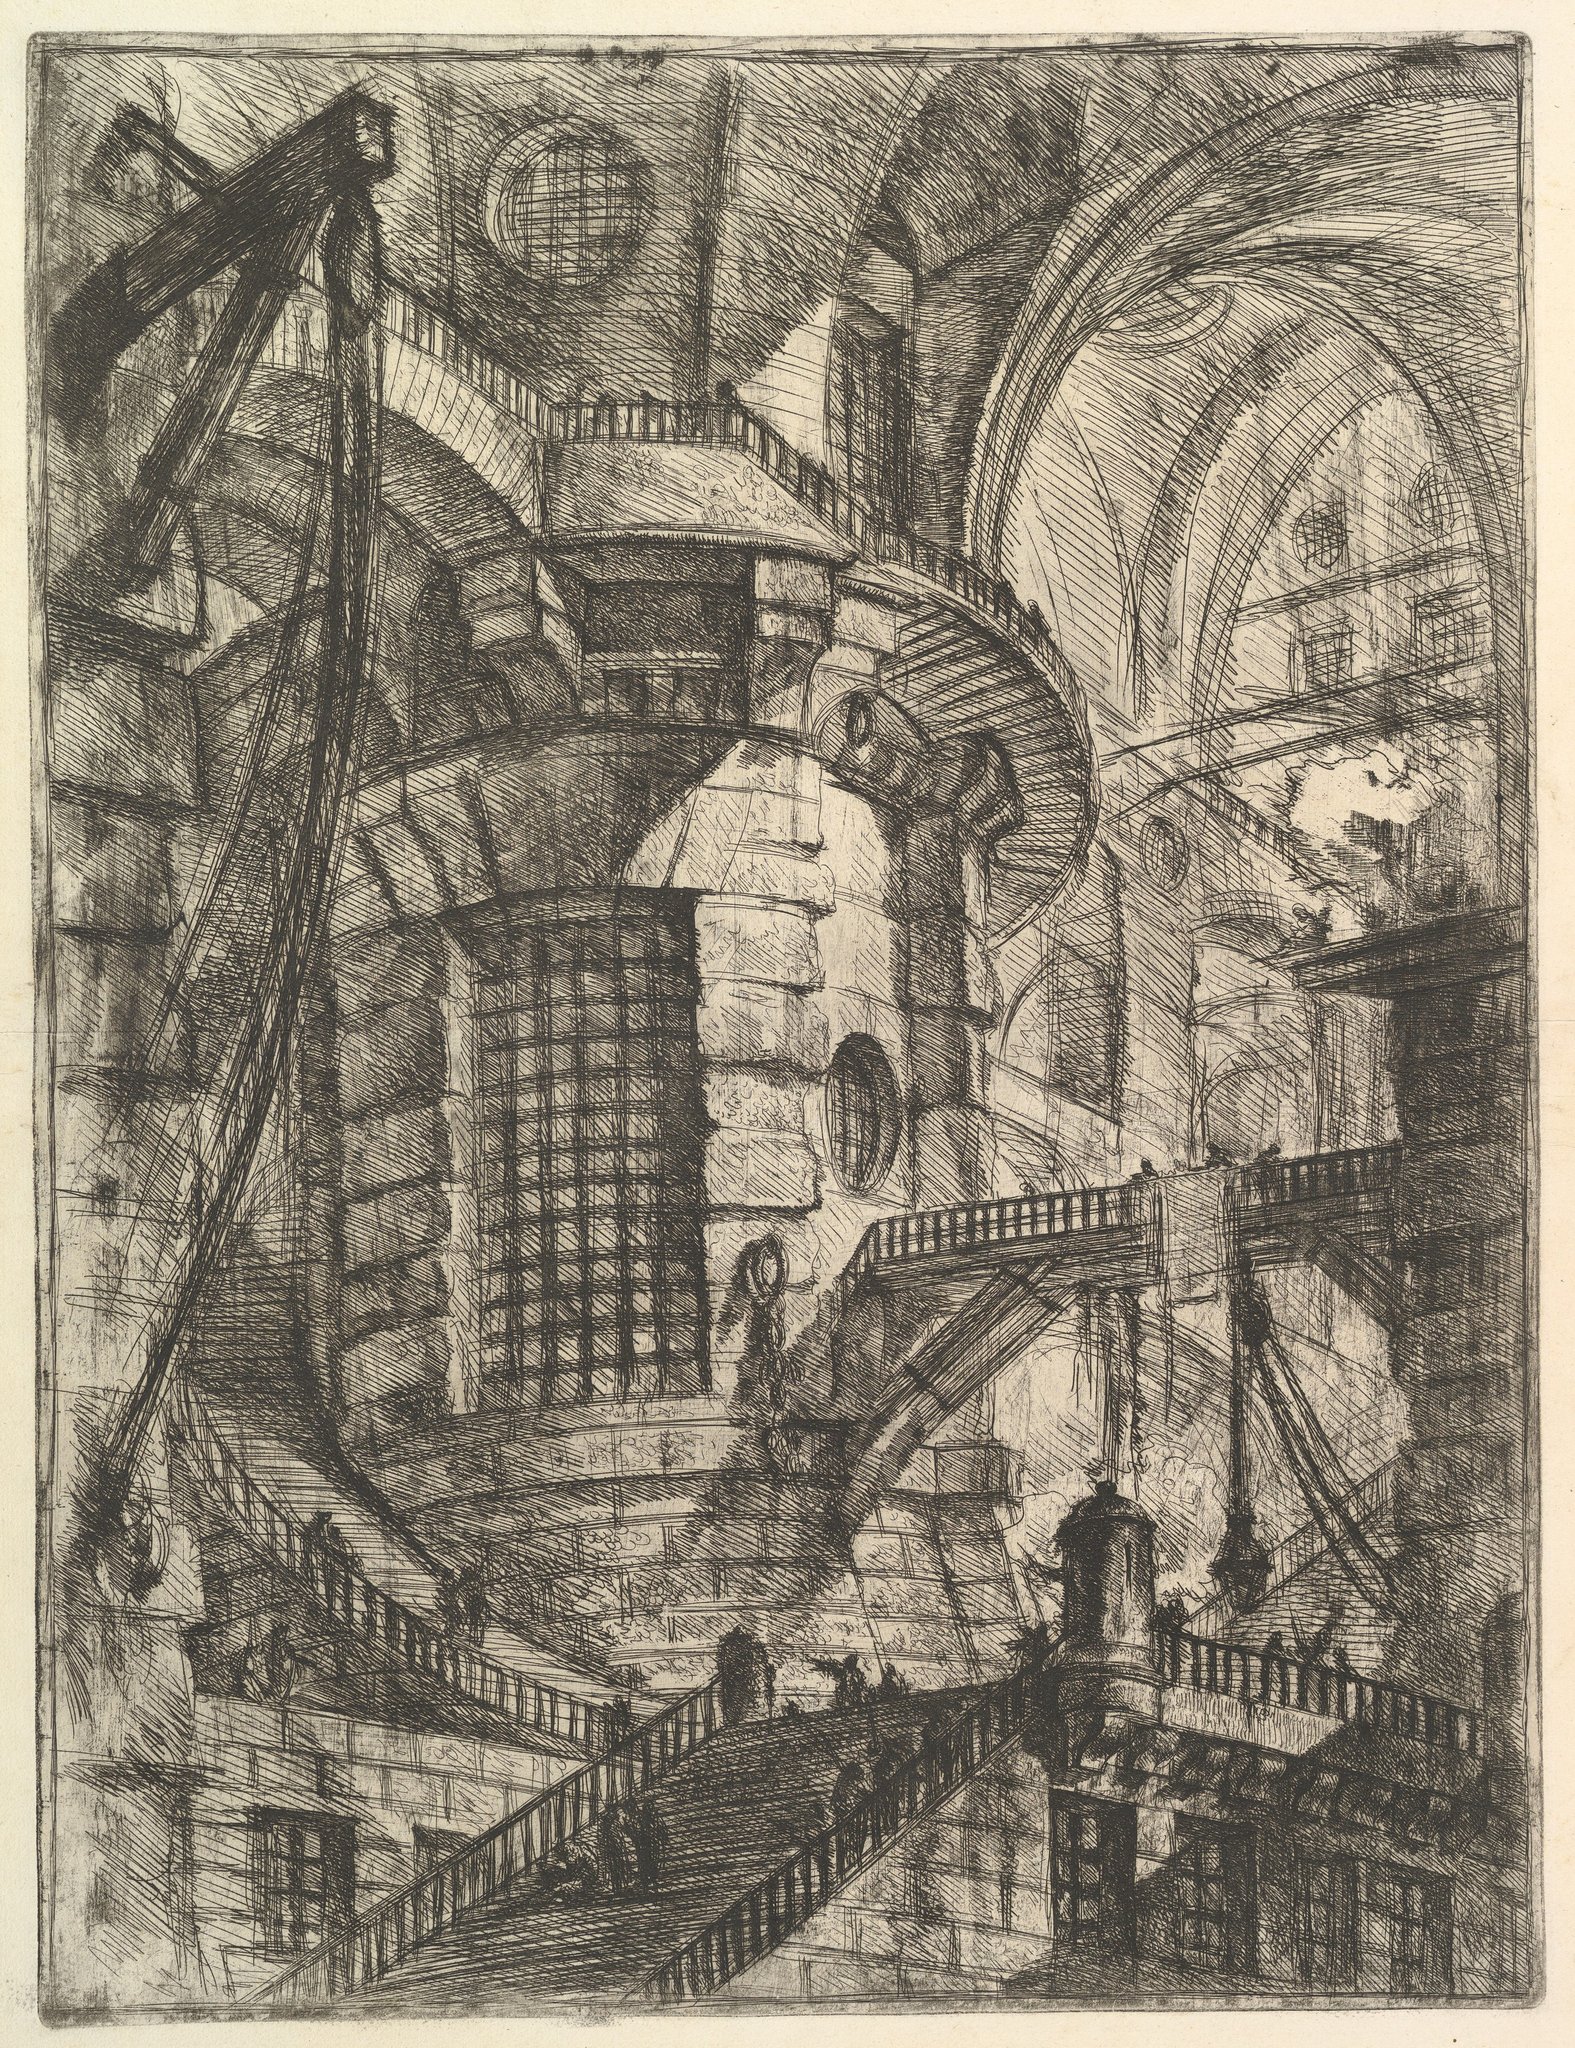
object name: print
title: The Round Tower, from "Carceri d'invenzione" (Imaginary Prisons)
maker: giovanni battista piranesi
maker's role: artist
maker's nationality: italian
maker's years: 1720-1778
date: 1749-1750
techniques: burnishing, engraving, etching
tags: prisons,stairs